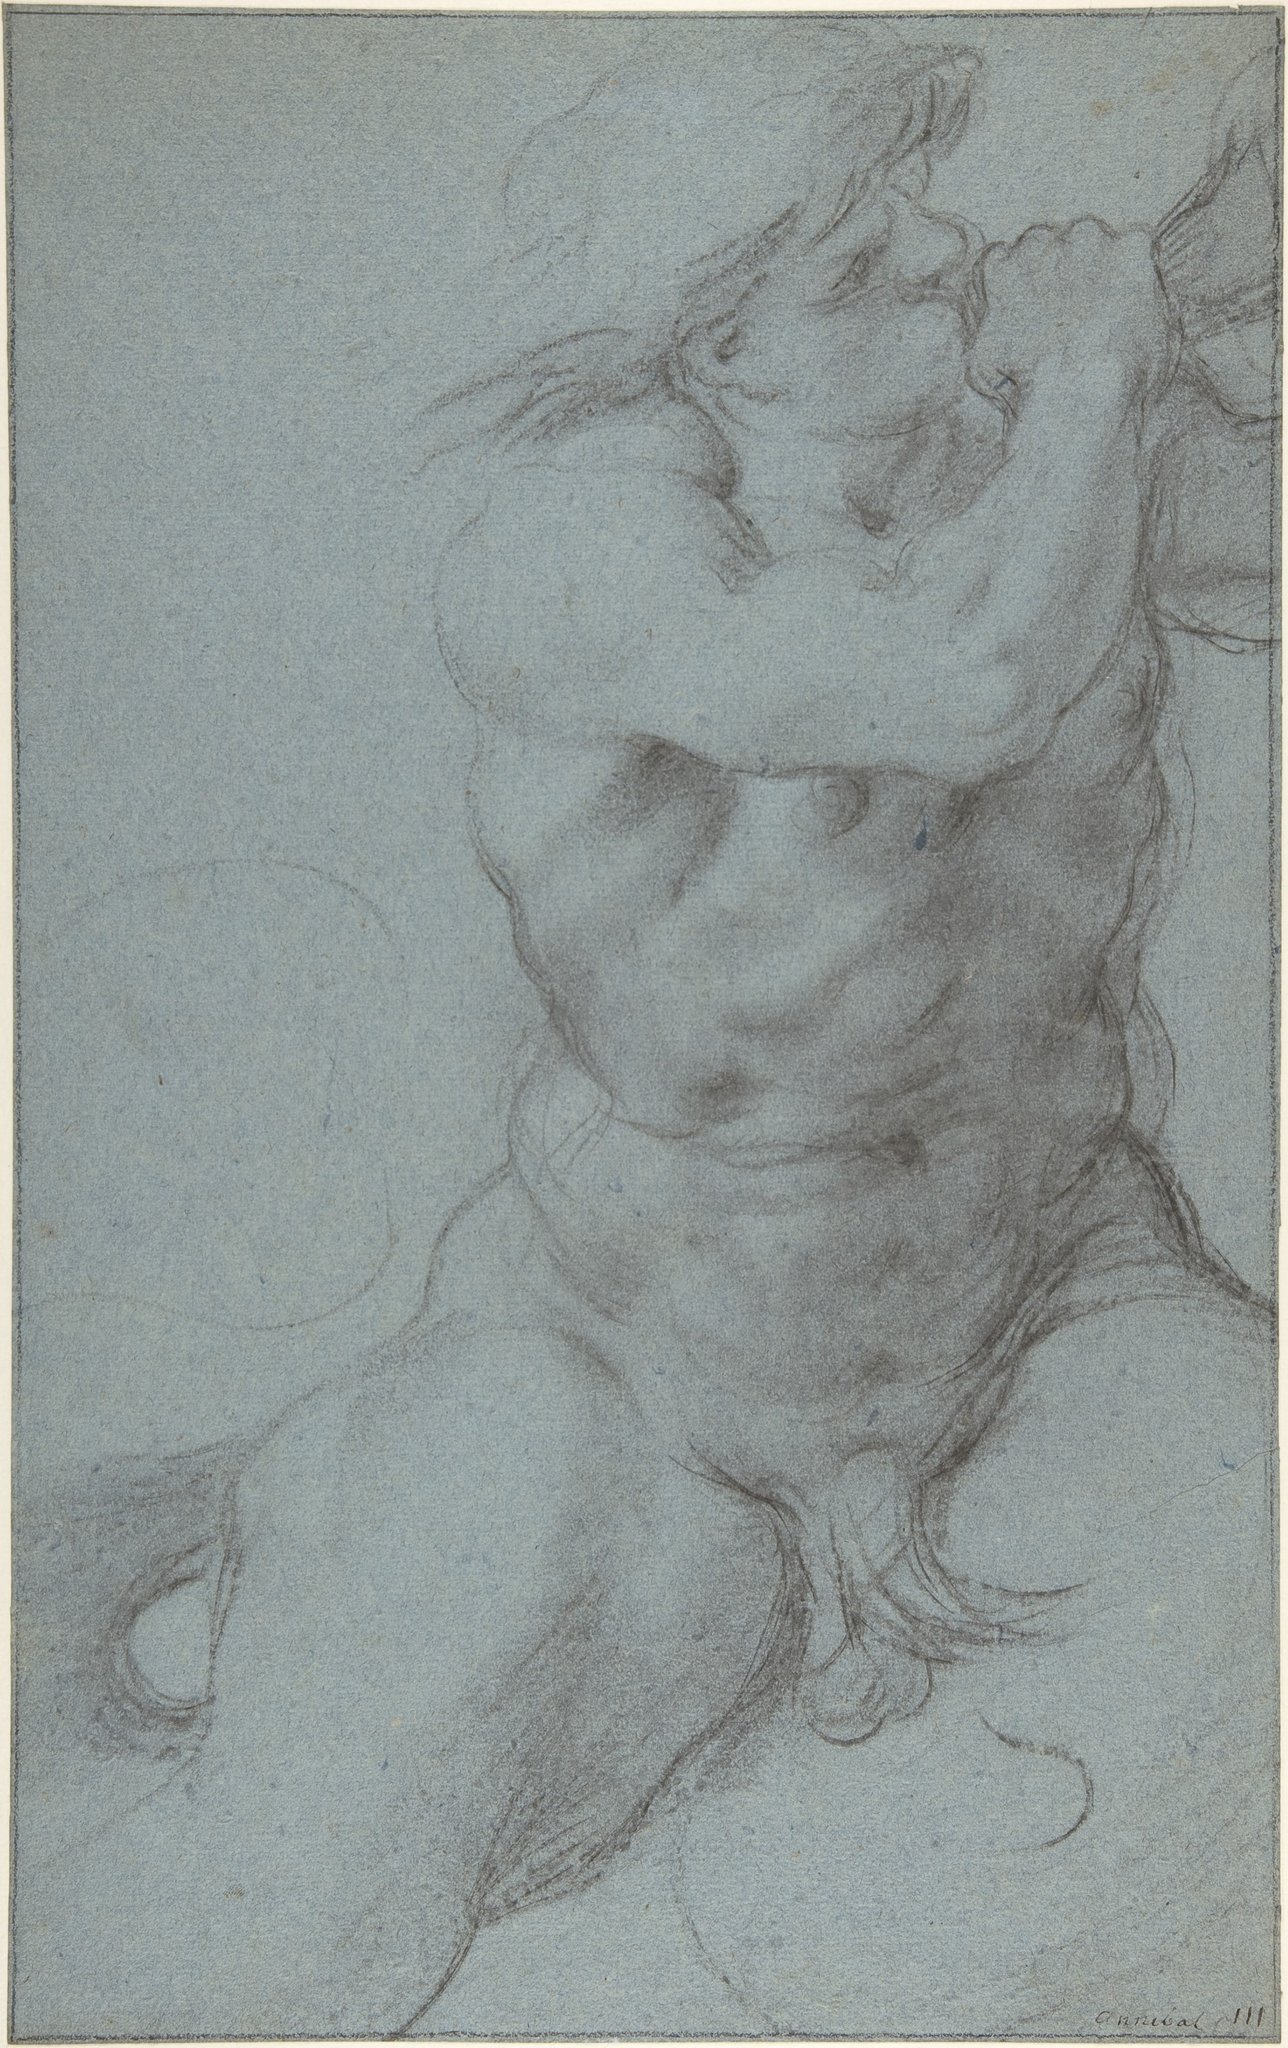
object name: drawing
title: Triton Sounding a Conch Shell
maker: annibale carracci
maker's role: artist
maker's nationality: italian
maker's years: 1560-1609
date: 1597-1602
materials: chalk, charcoal, ink, paper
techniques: pen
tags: male nudes,triton